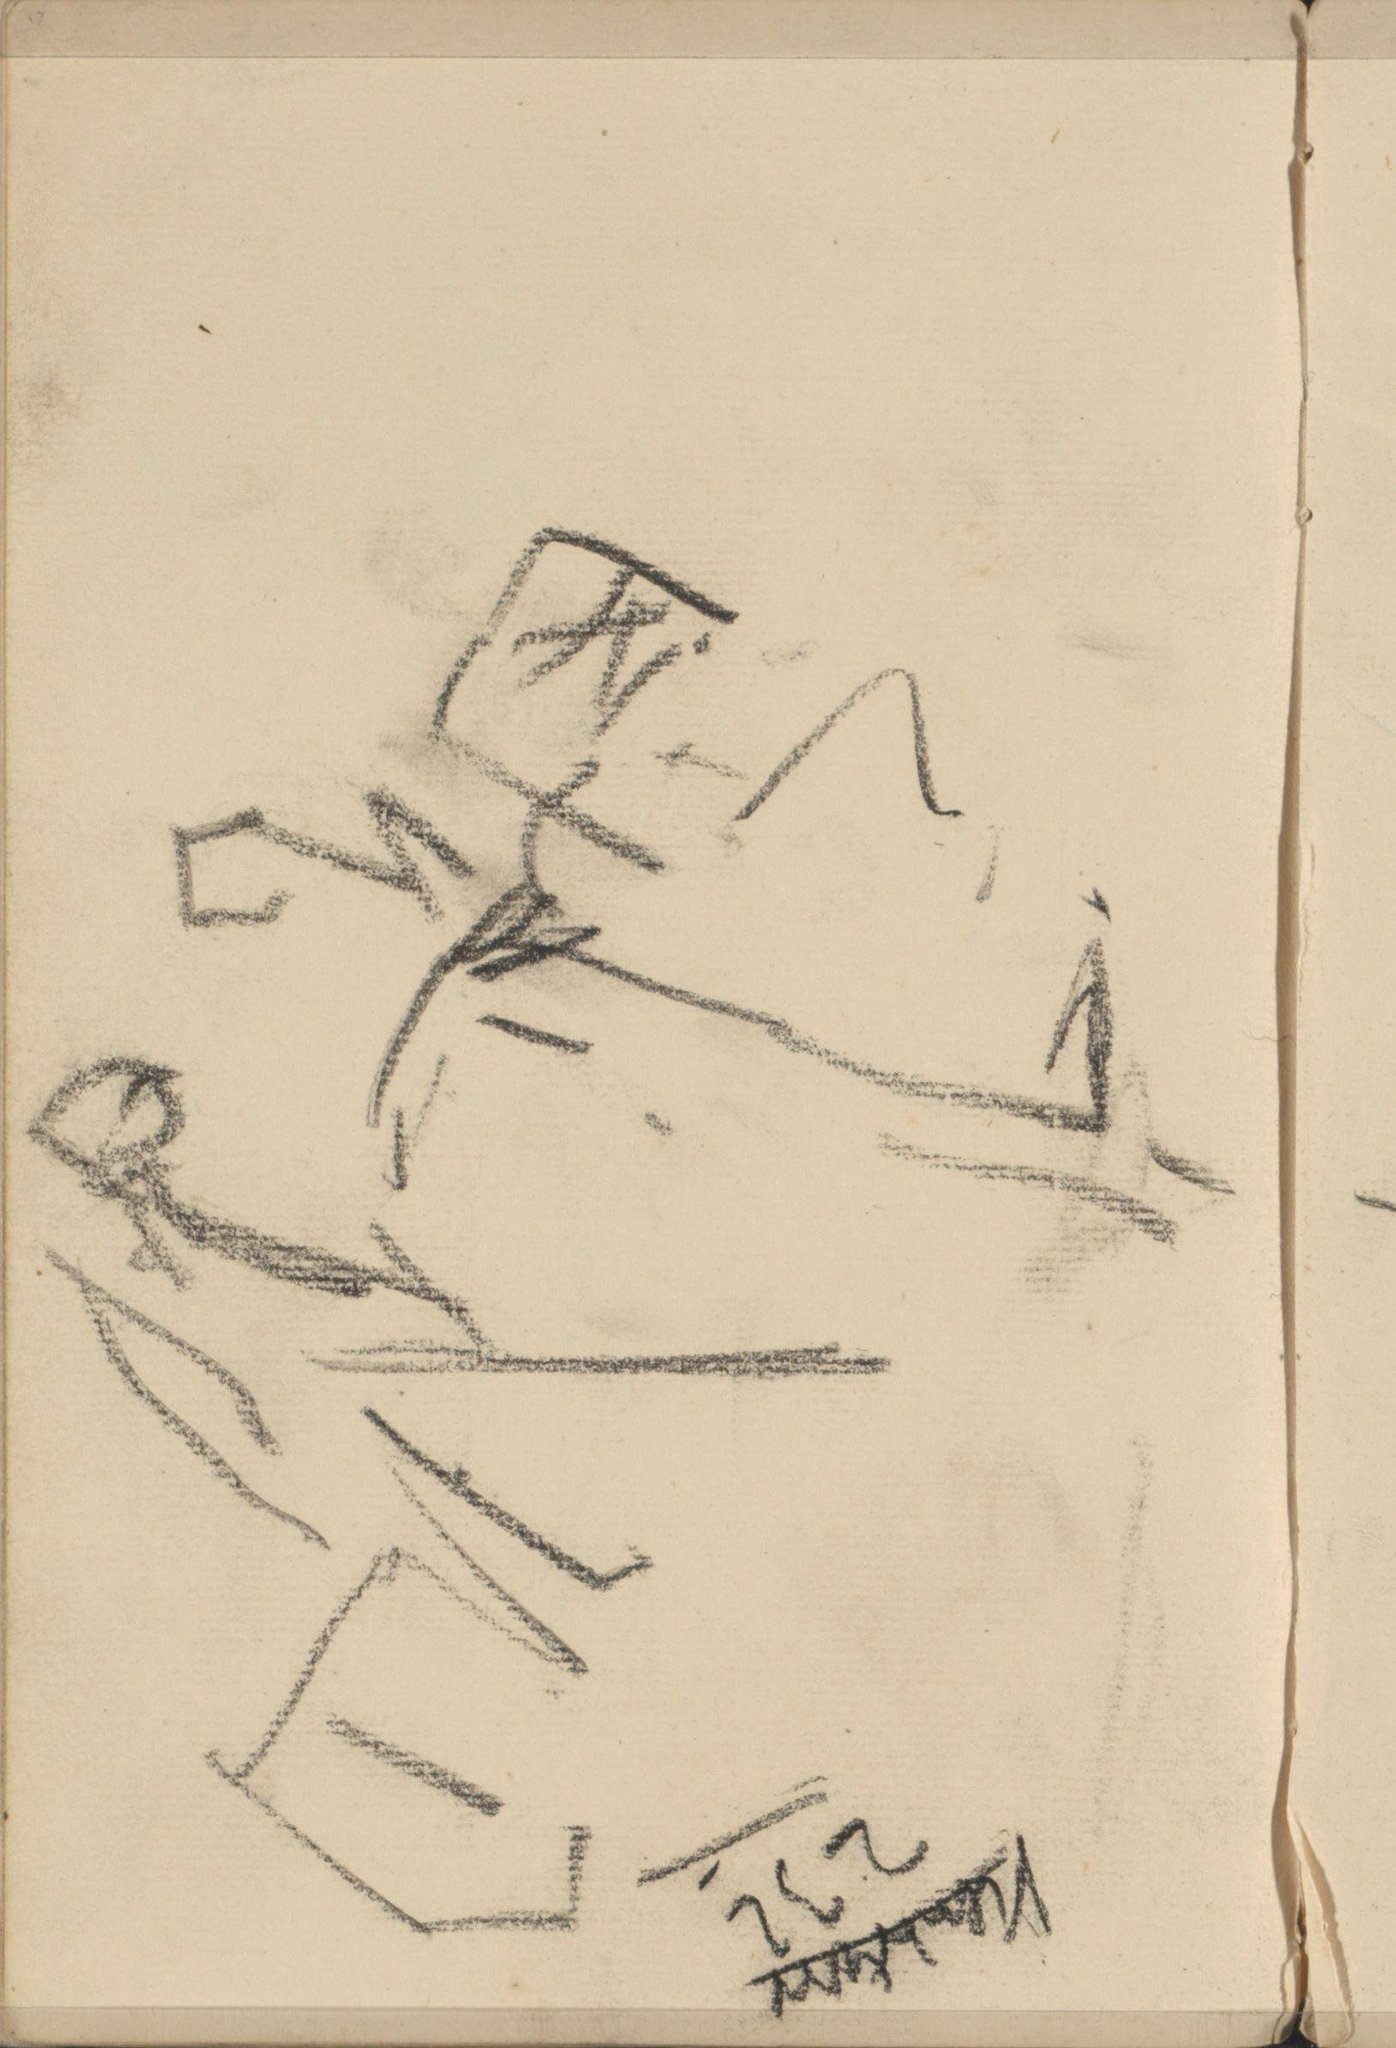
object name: sketchbook leaf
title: Twee ruiters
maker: george hendrik breitner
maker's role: draughtsman, painter, print maker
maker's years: 1857-1923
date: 1884-1886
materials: chalk, paper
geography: the hague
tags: riding a horse, ass, or mule; rider, horseman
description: Pagina 17 uit een schetsboek met 19 bladen.